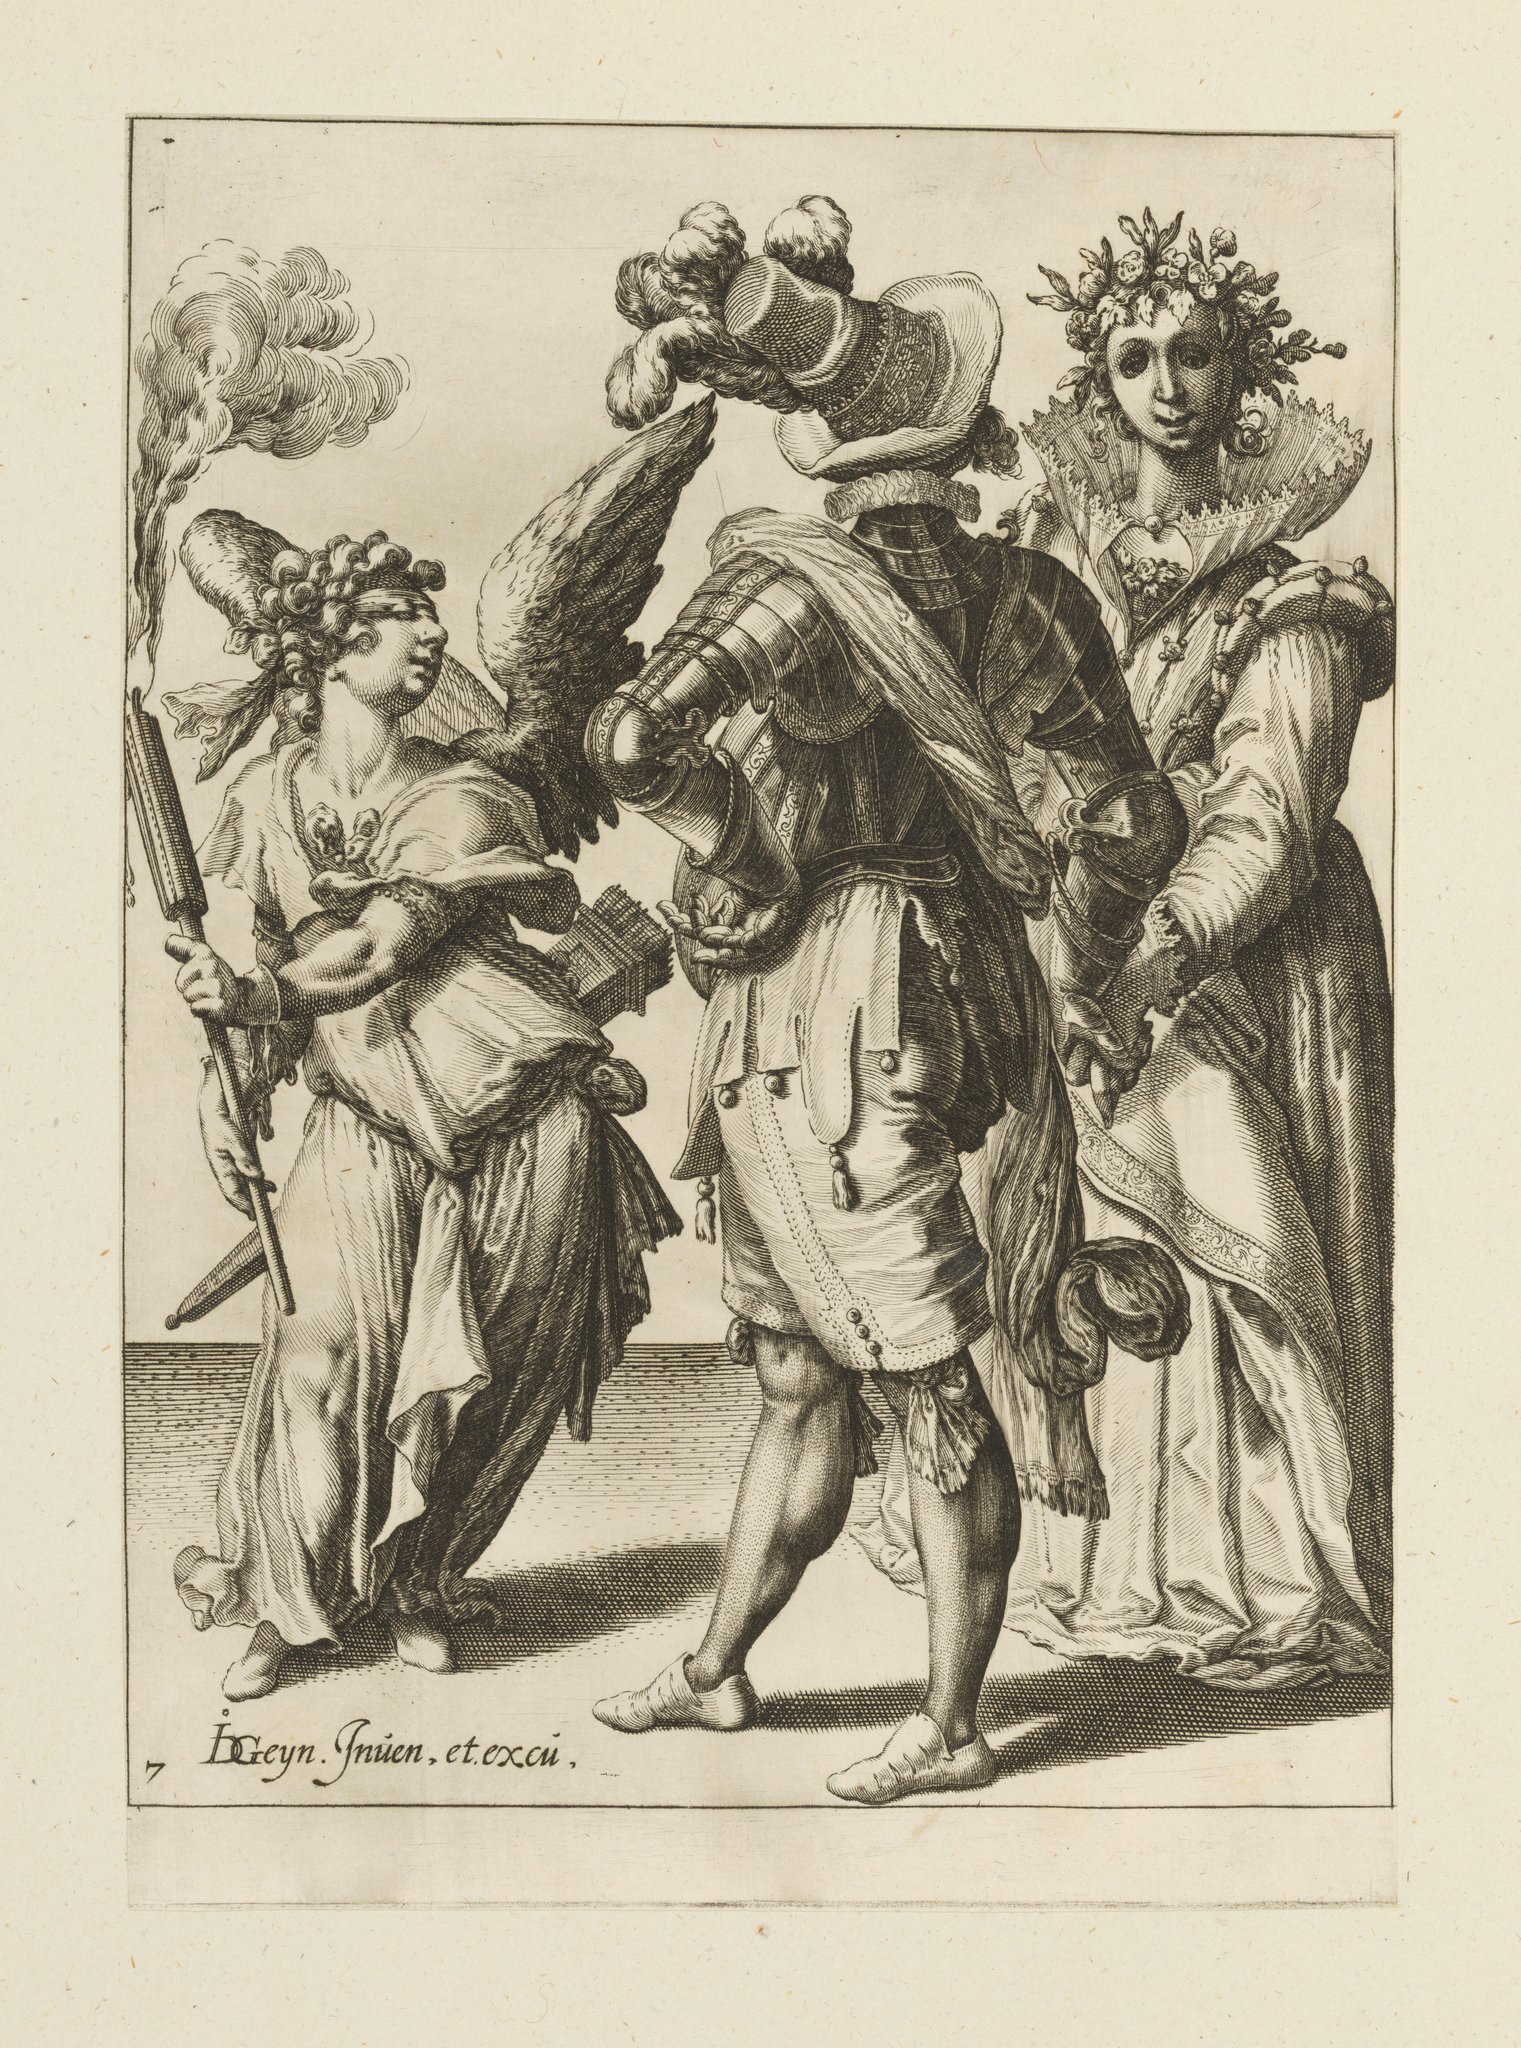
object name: print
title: A Blindfolded Cupid Holding a Torch before a Couple, plate 7 from "The Masquerades"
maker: jacques de gheyn (ii)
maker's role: artist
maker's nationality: netherlandish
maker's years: 1565-1629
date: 1595-1596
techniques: engraving